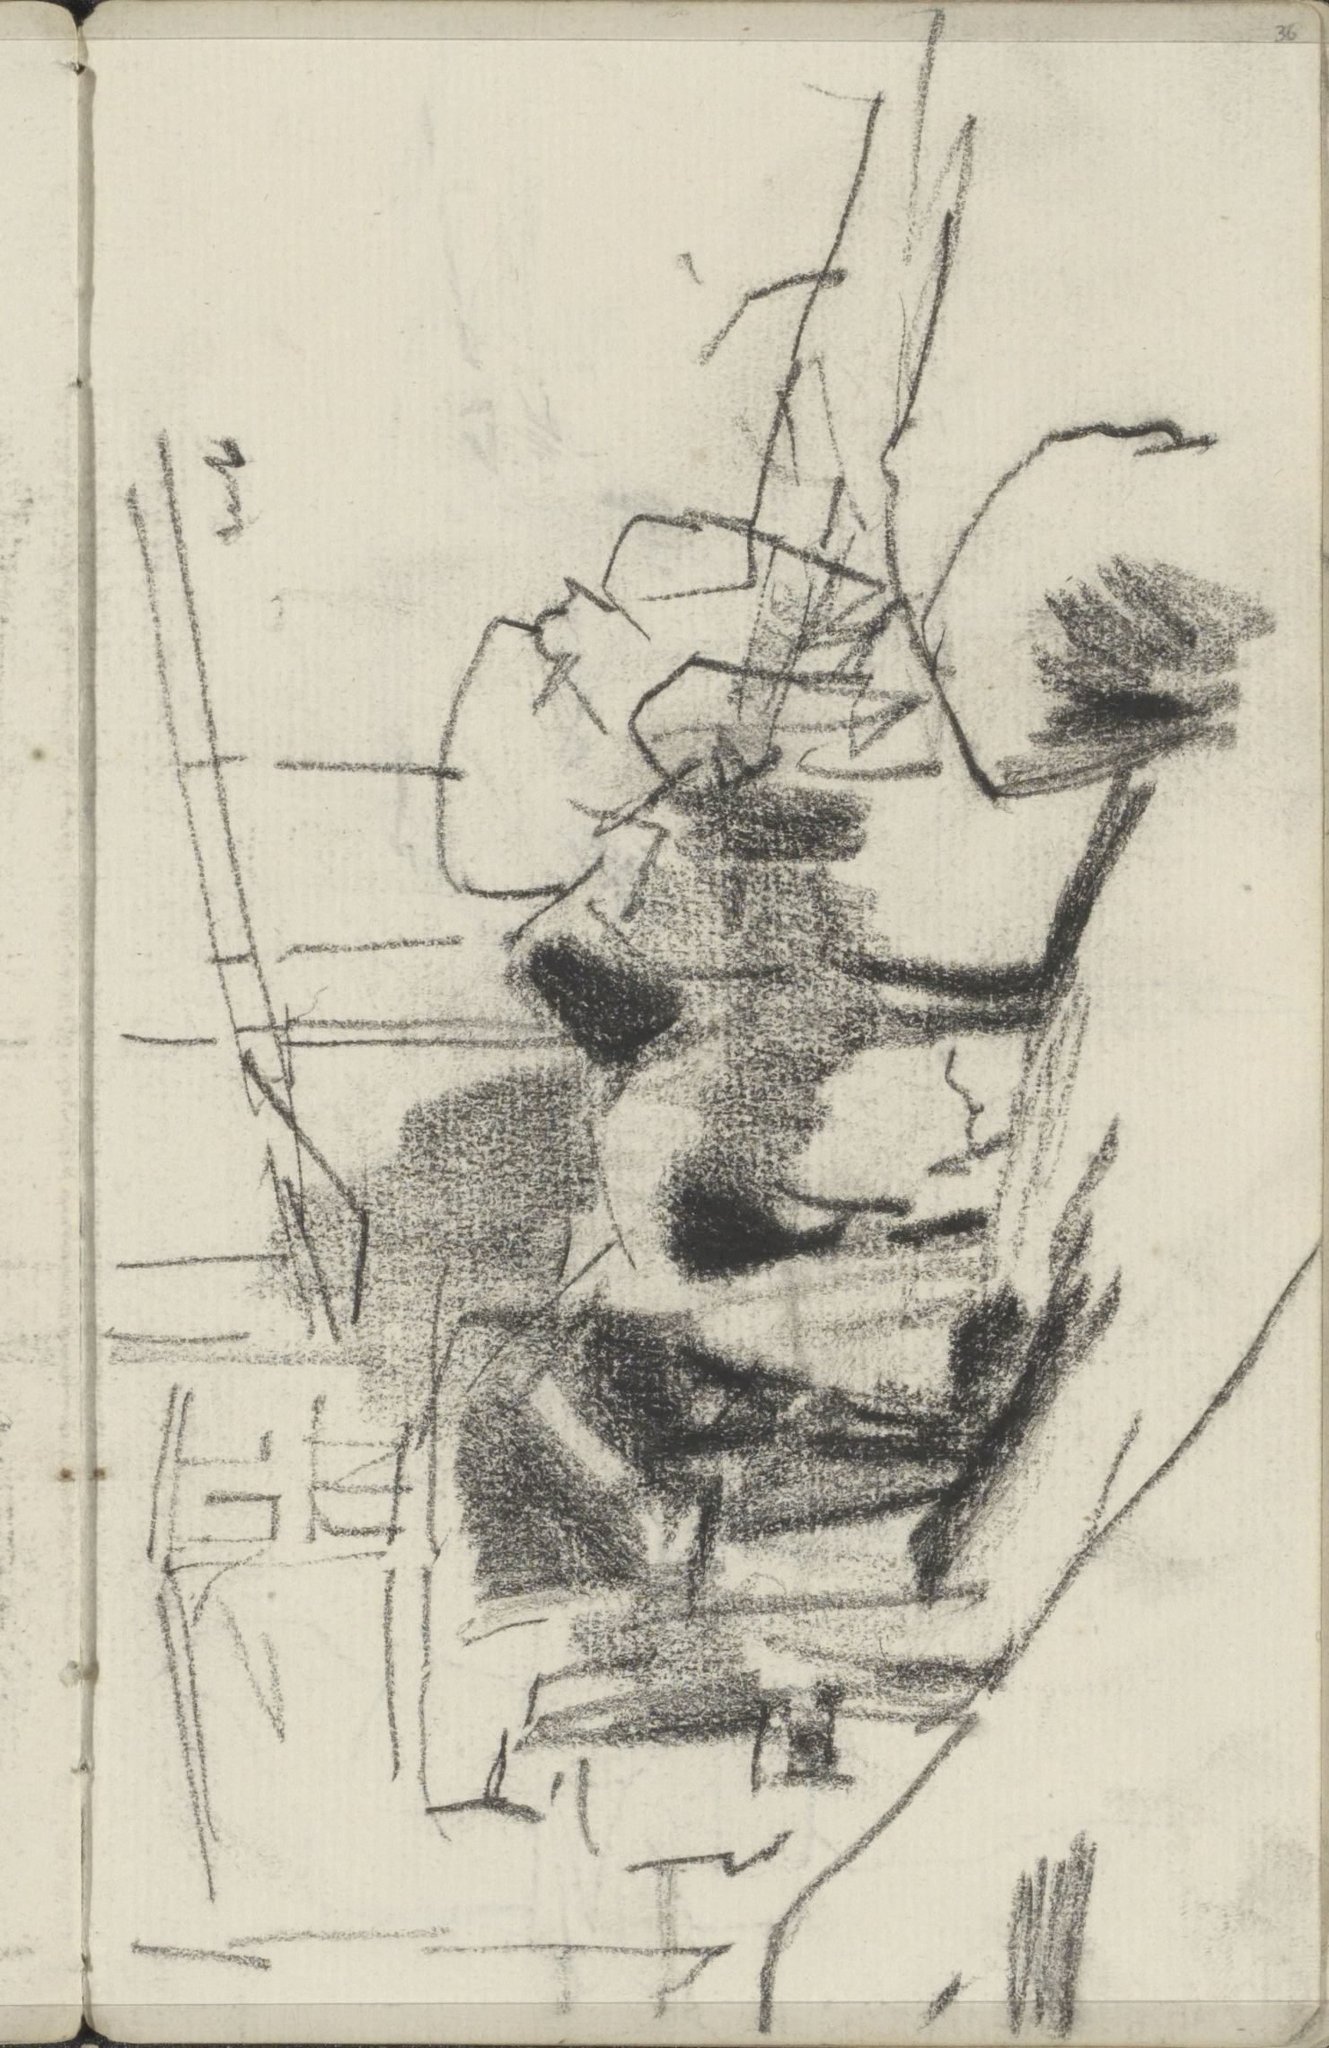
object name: sketchbook leaf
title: Gezicht op een straat met een paardenkar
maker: george hendrik breitner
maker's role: draughtsman, painter, print maker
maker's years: 1857-1923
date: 1884-1886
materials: chalk, paper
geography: paris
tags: two-wheeled, animal-drawn vehicle, civic architecture; edifices; dwellings, street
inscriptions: kleurnotitie, handgeschreven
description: Pagina 36 uit een schetsboek met 25 bladen.